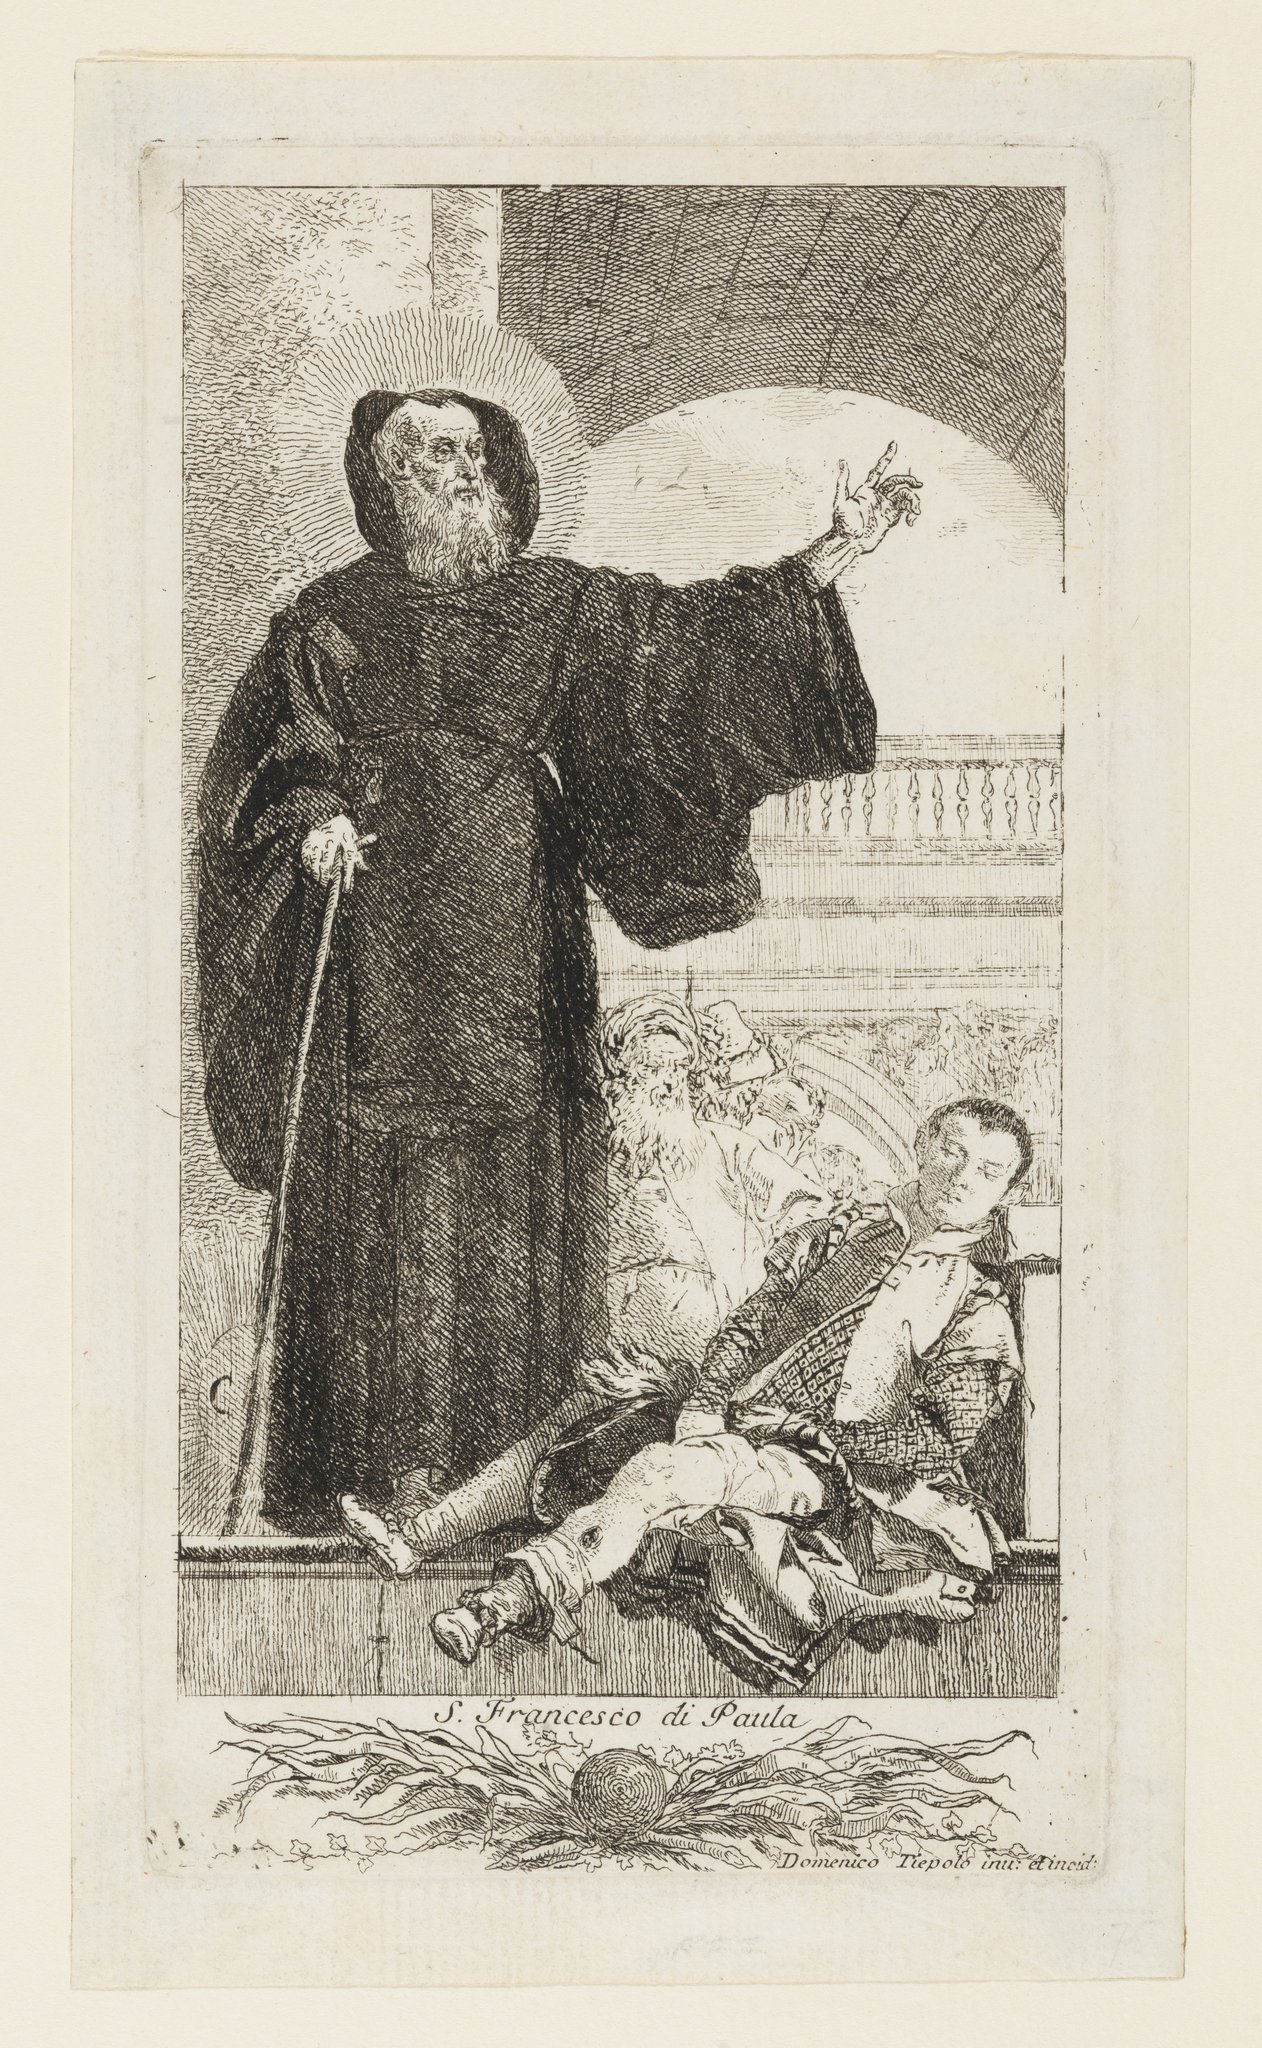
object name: print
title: Saint Francis of Paolo miraculously healing a man possessed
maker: giovanni domenico tiepolo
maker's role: artist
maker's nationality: italian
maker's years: 1727-1804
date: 1750-1770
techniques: etching